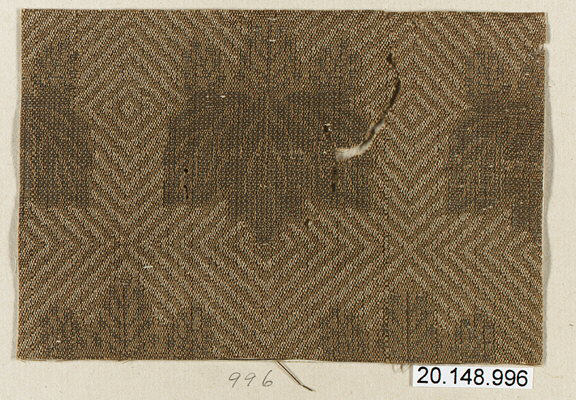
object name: piece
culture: japanese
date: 1801-1900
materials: silk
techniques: compound weave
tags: leaves